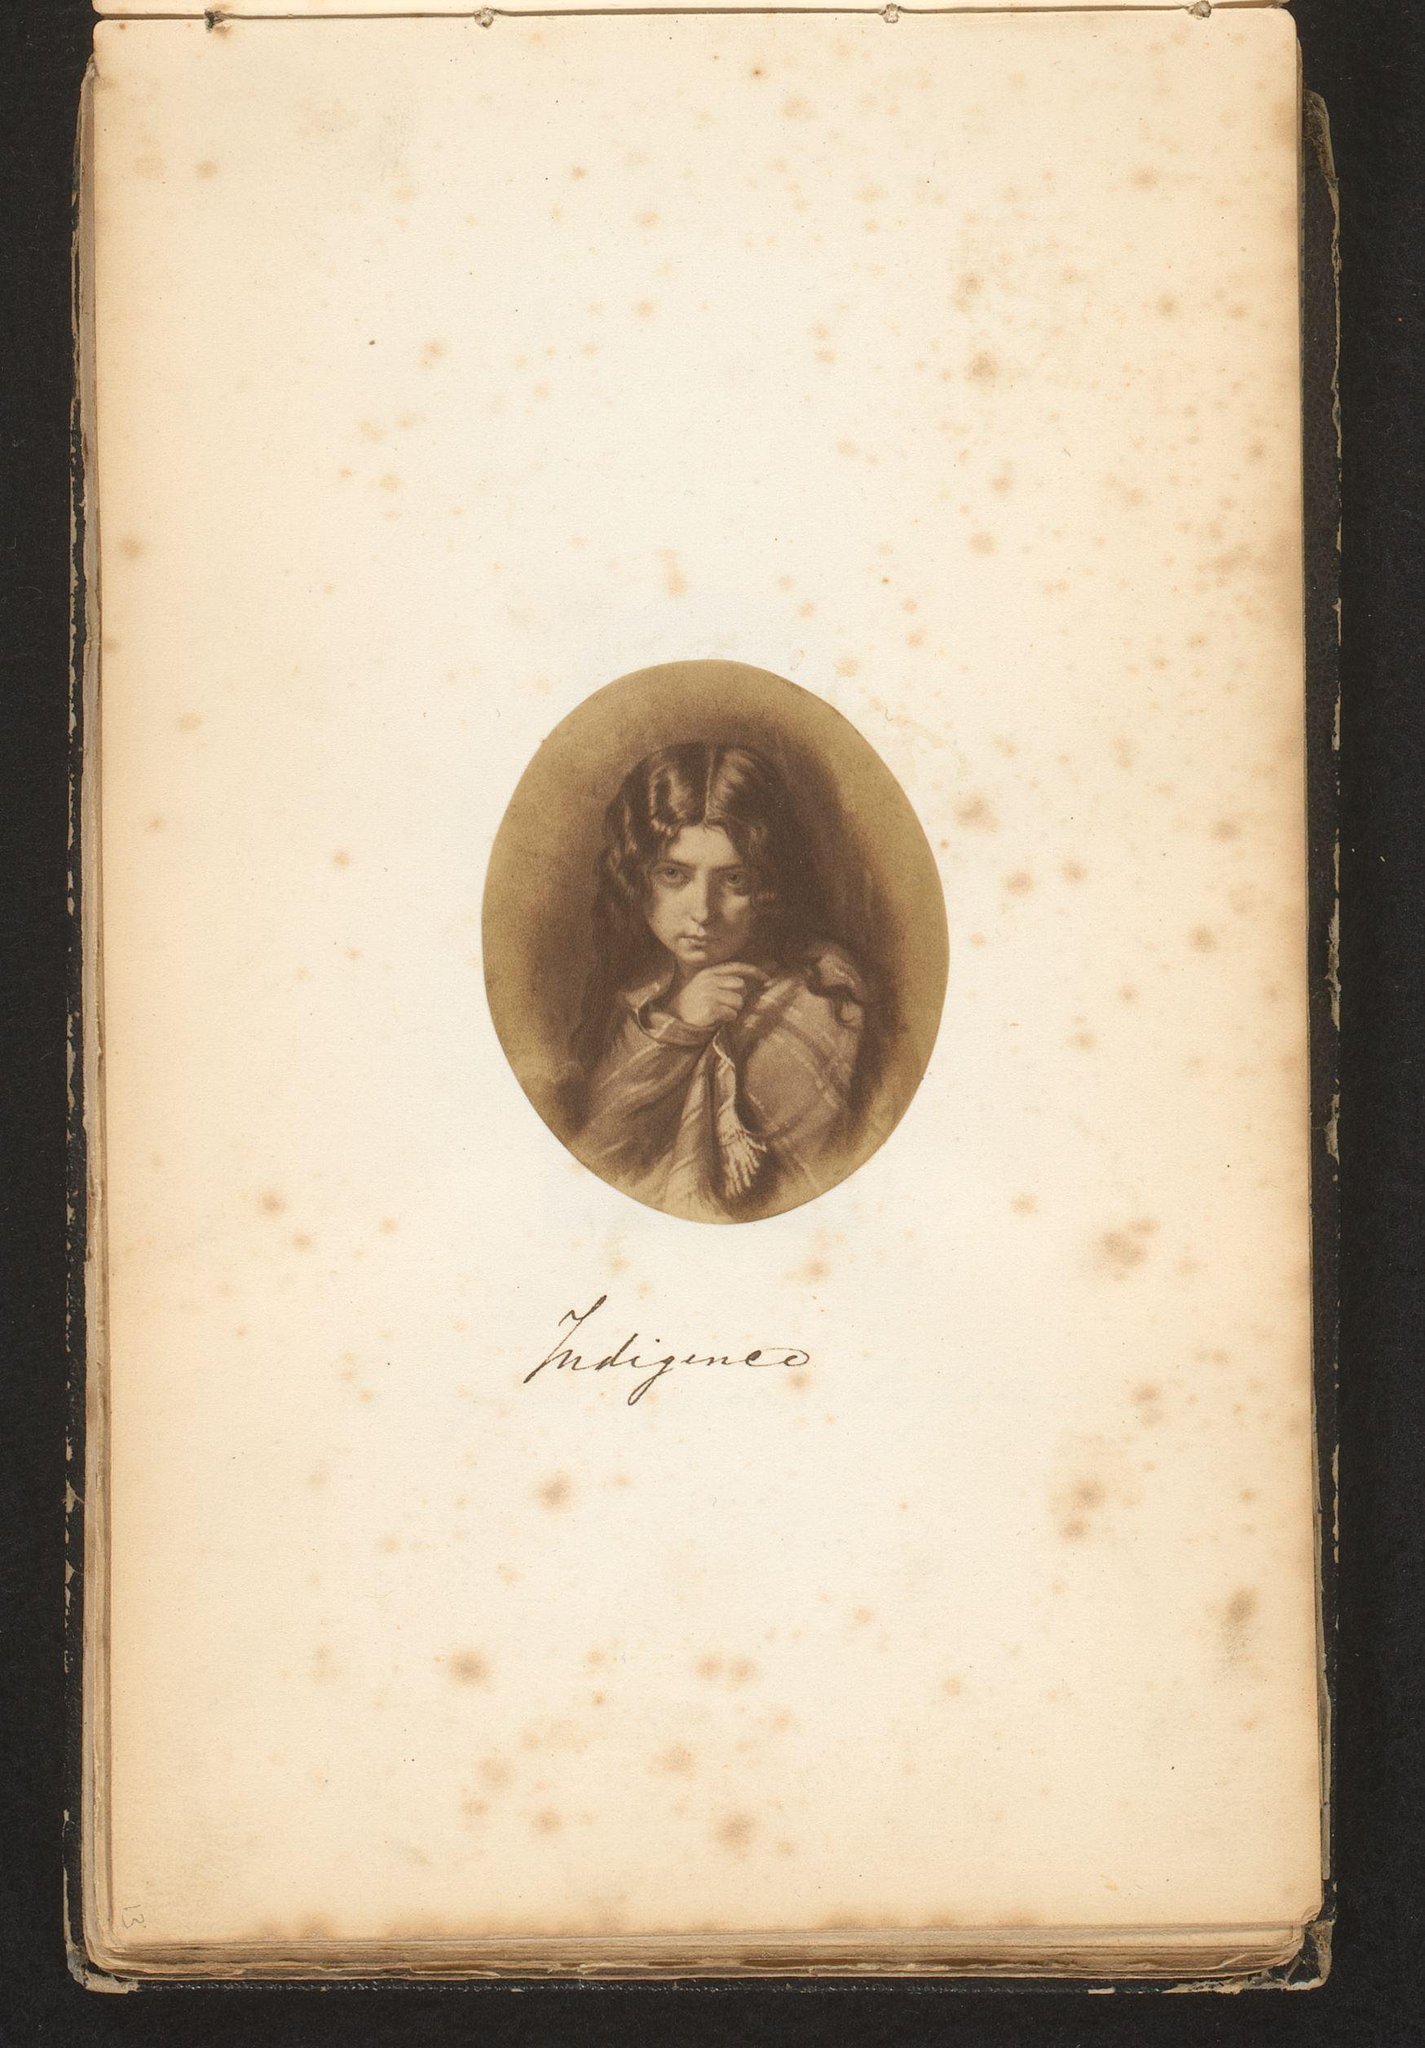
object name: album leaf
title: Fotoreproductie van een geschilderd portret van een vrouw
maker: Anonymous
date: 1860-1900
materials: photographic support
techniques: albumen print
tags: adult woman, painting, drawing and the graphic arts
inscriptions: annotation: ‘Indigence’